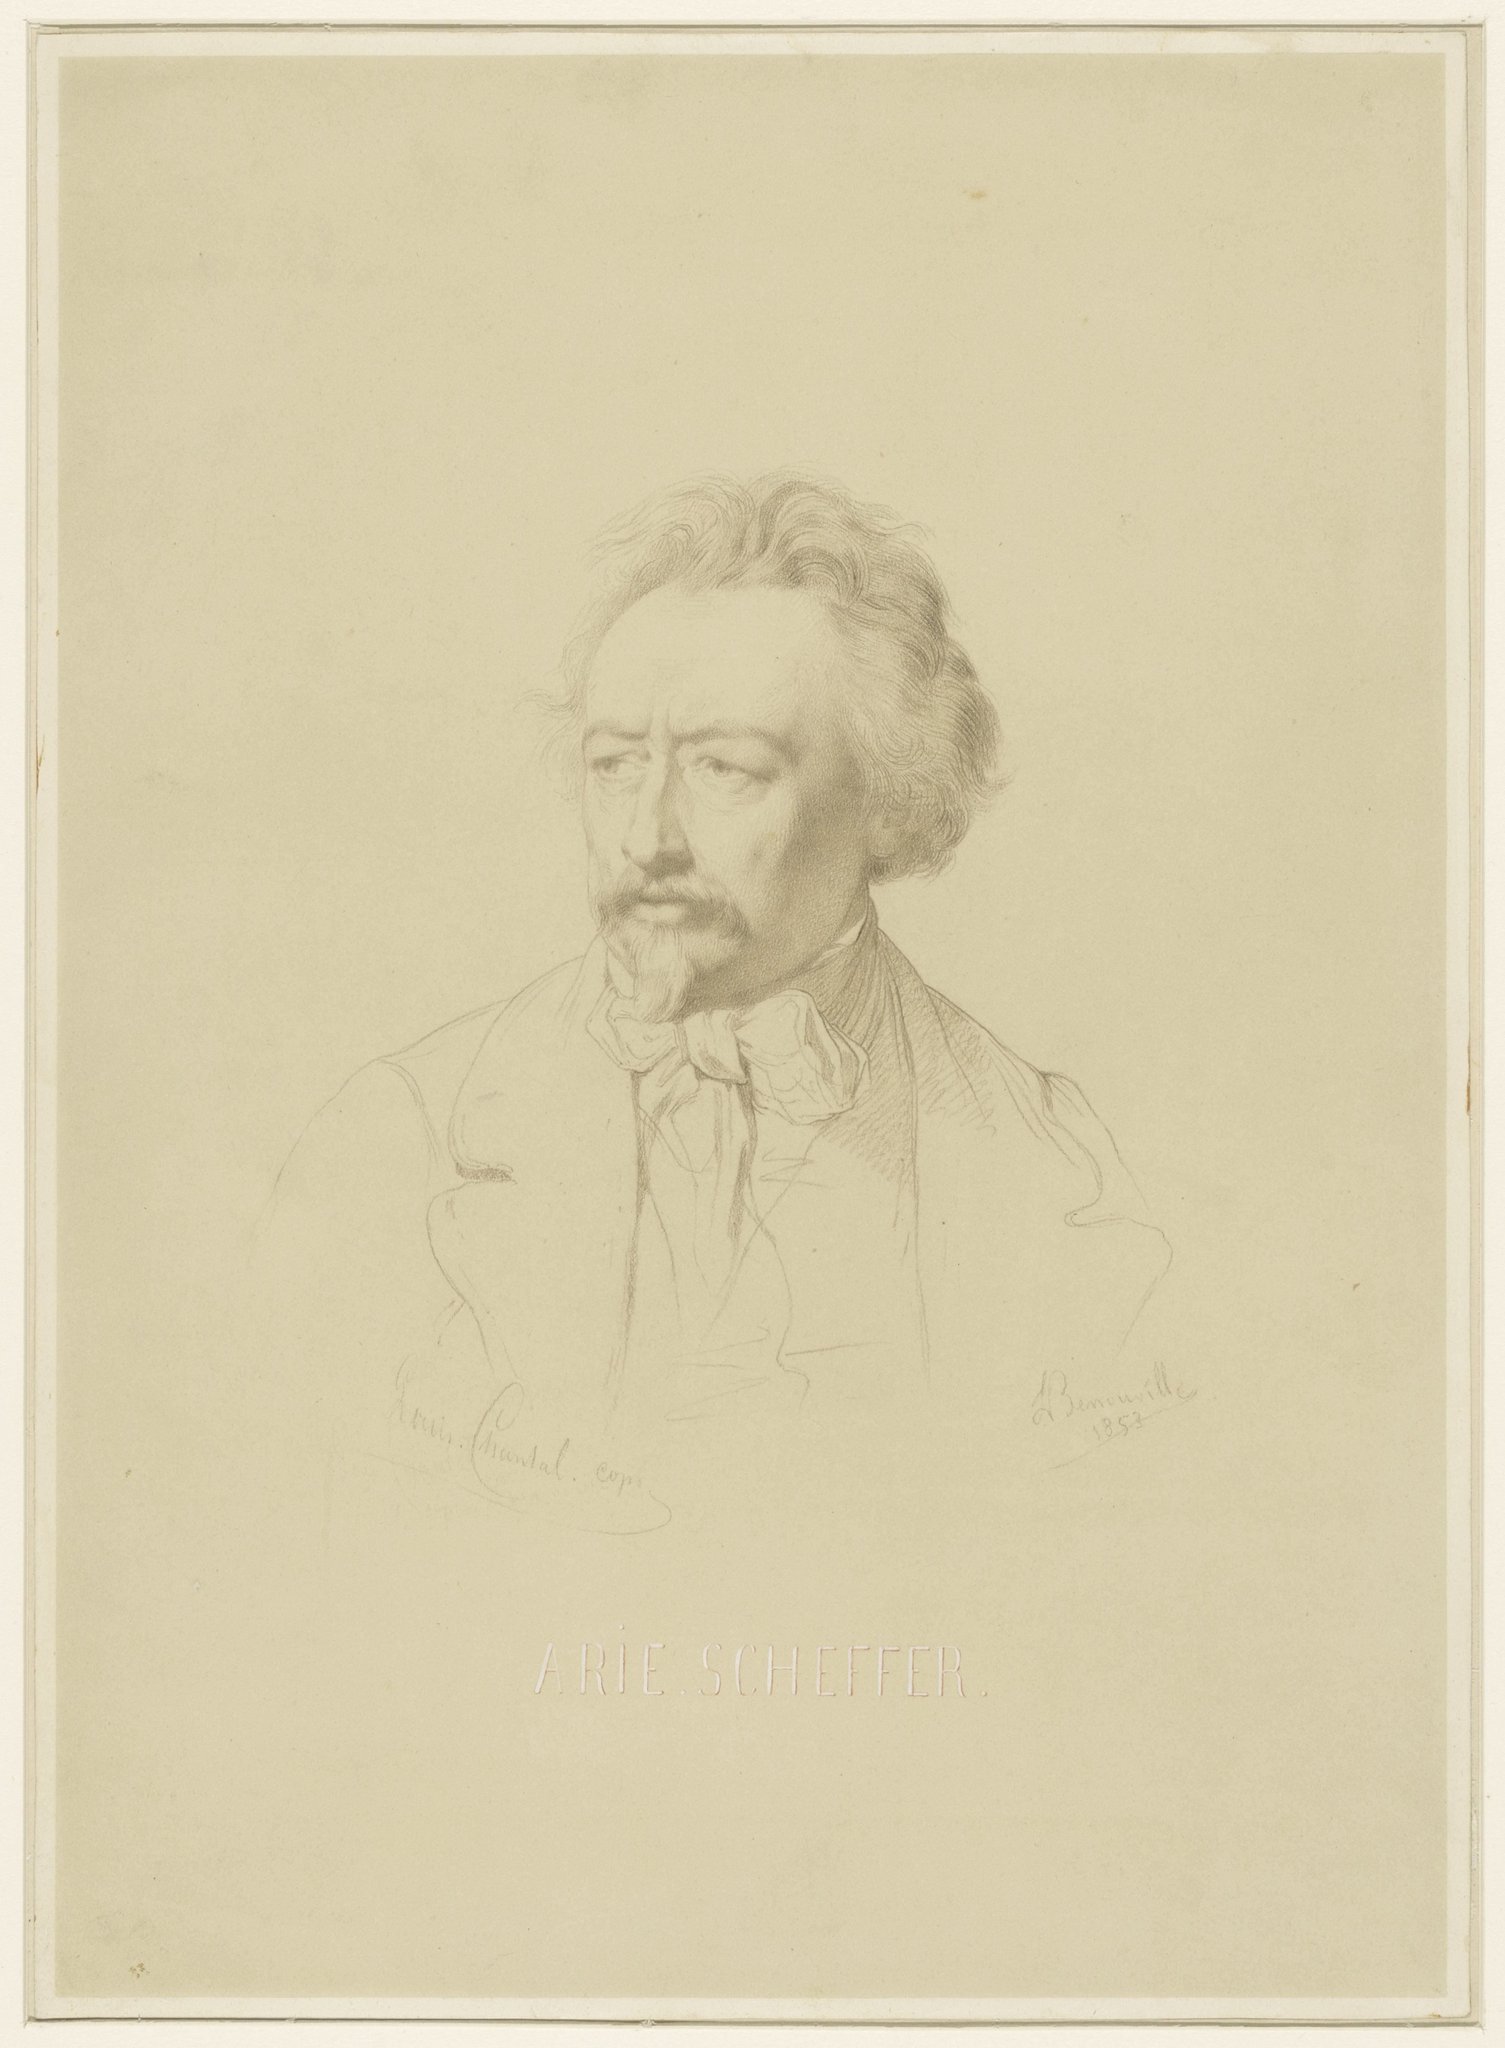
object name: drawing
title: Portret van Ary Scheffer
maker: louis chantal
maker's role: draughtsman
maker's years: 1822-1899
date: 1832-1899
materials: chalk, paper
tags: dordrecht, painter, print maker, draughtsman, sculptor, ary scheffer, historical persons, portrait, self-portrait of painter, portrait, self-portrait of artist